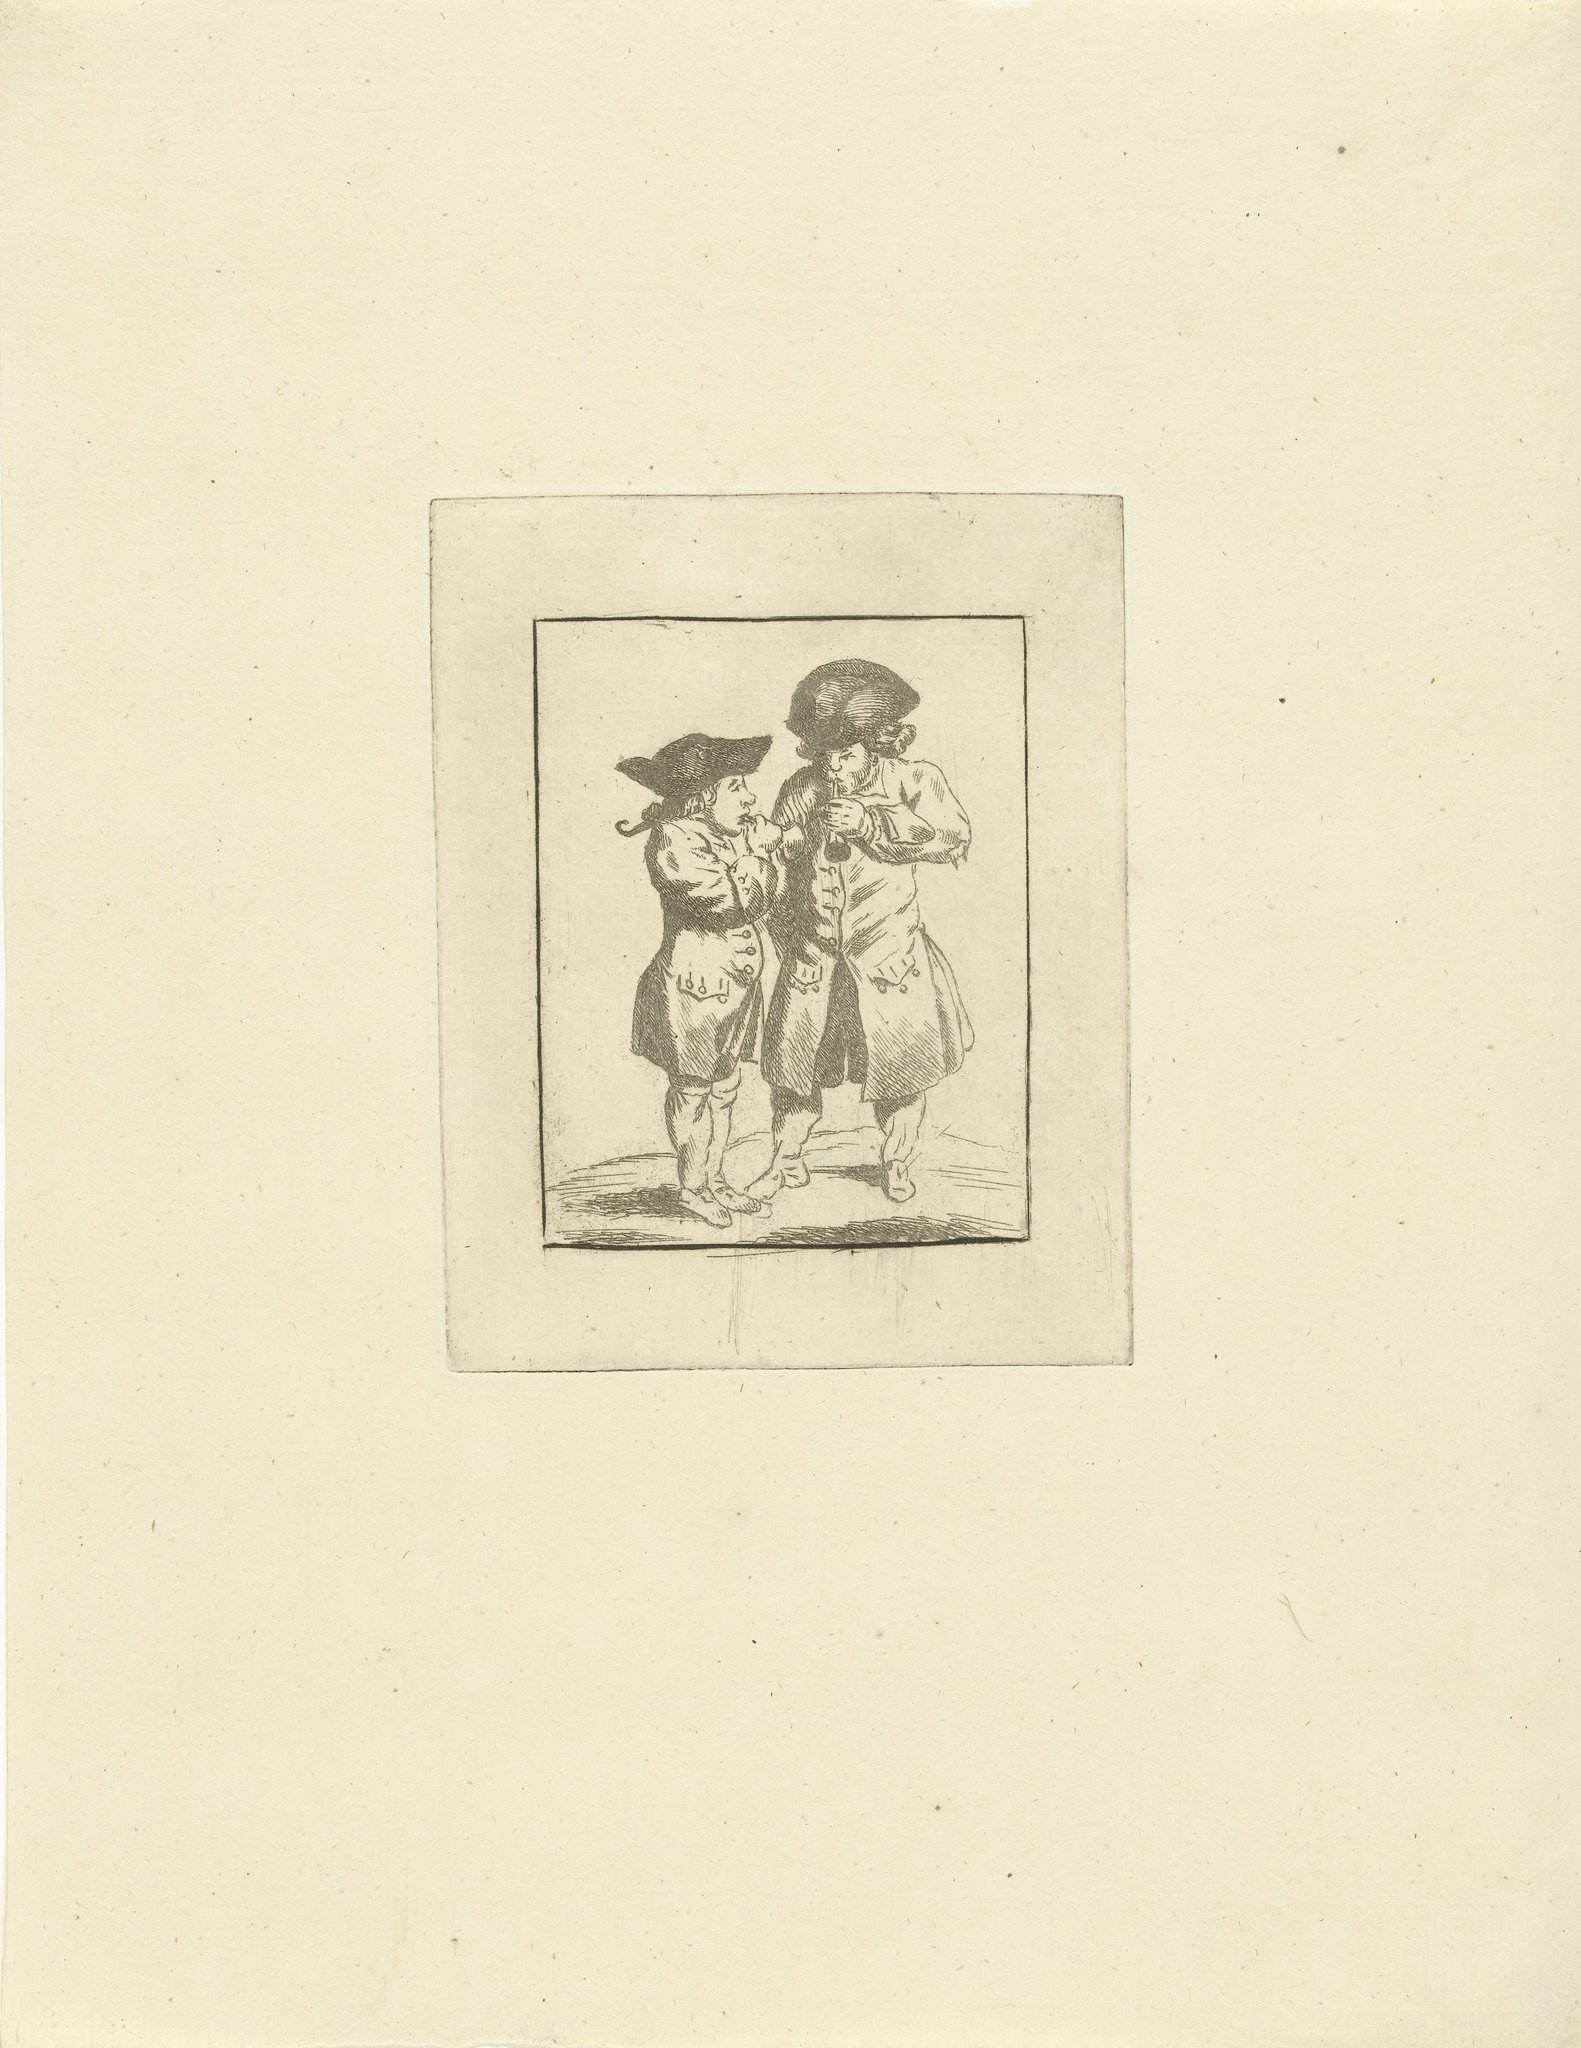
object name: print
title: Twee soldaten met driepuntige hoeden blazen op bazuinen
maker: g. van citters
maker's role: print maker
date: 1750-1800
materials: paper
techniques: etching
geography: netherlands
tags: horn, trumpet, cornet, trombone, tuba, (military) signals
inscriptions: collector's mark: Lugt 2233